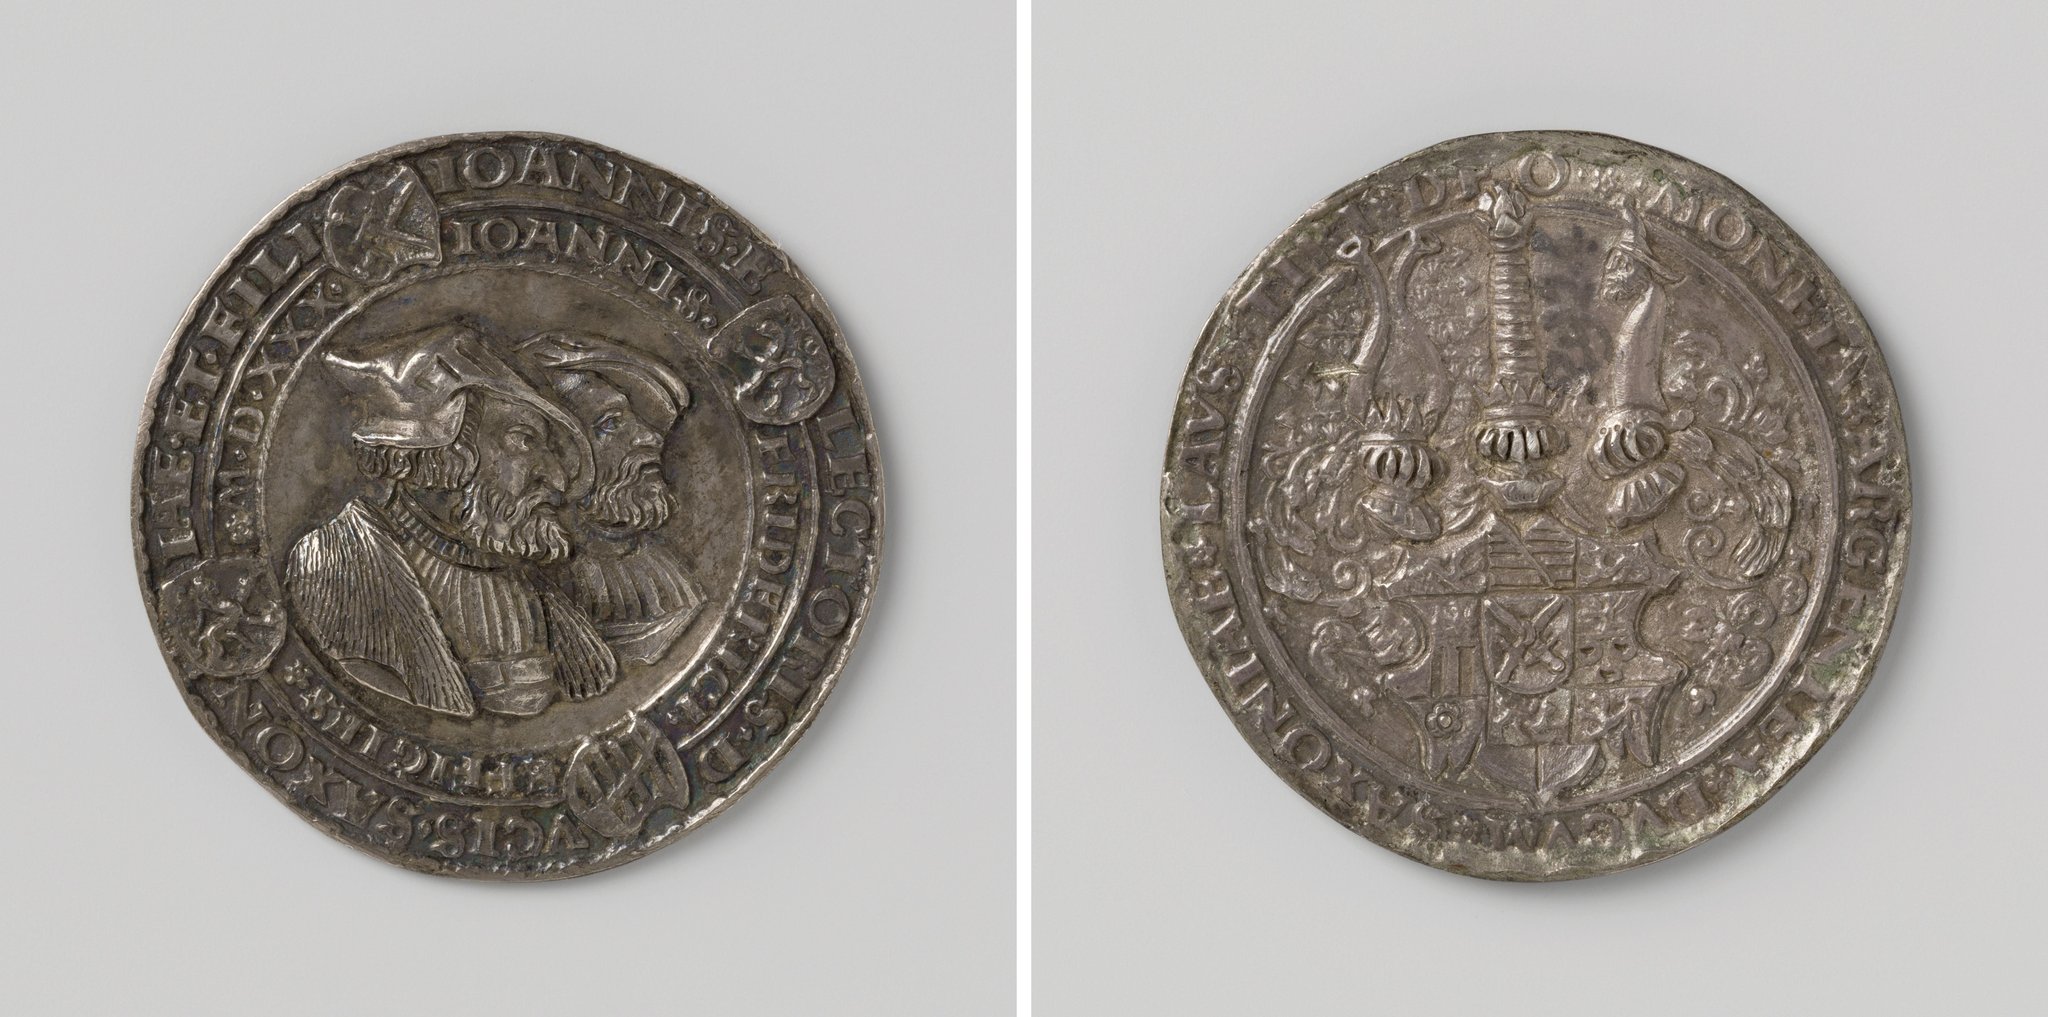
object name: history medal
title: Johan de Standvastige, keurvorst van Saksen en zijn zoon Johan Frederik de Grootmoedige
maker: hieronymus magdeburger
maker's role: die cutter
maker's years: 1492-1540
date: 1530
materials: silver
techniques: casting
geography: saxony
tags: meissen, keurvorst van saksen johan de standvastige, torgau, weimar, keurvorst, johan frederik i (keurvorst van saksen)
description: Zilveren penning. Voorzijde: borststukken van twee mannen binnen tweeregelig omschrift onderbroken door vier wapenschilden. Keerzijde: wapenschild met drie helmen binnen omschrift